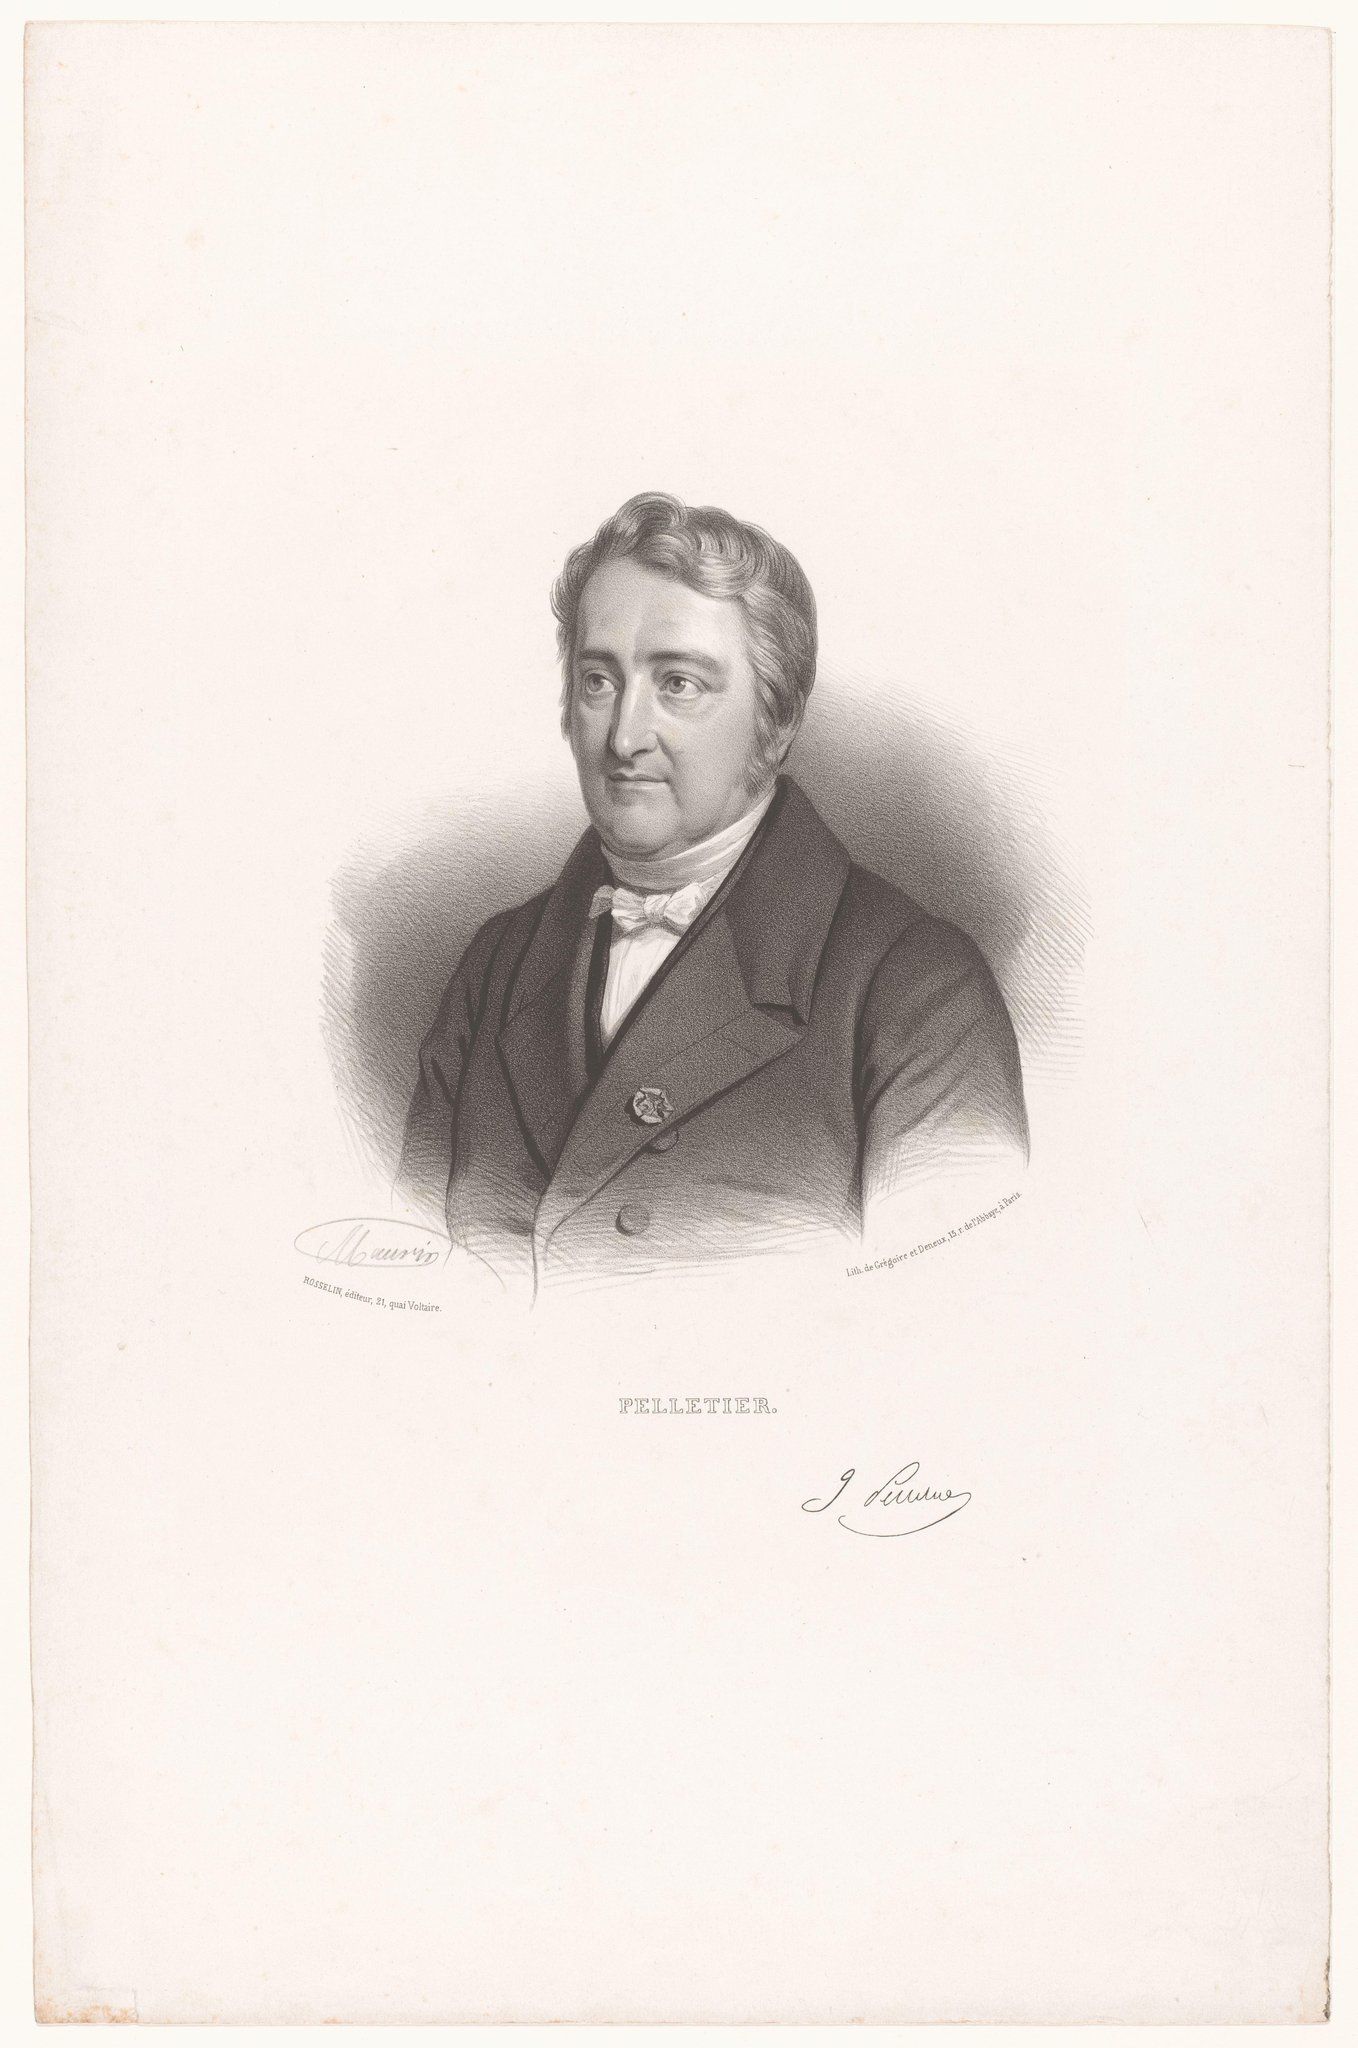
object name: print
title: Pelletier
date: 1835-1851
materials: paper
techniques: lithograph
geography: paris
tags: pharmacist, druggist, apothecary; pharmacy, drugstore, dispensing chemist, historical persons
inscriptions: collector's mark: Lugt 2228